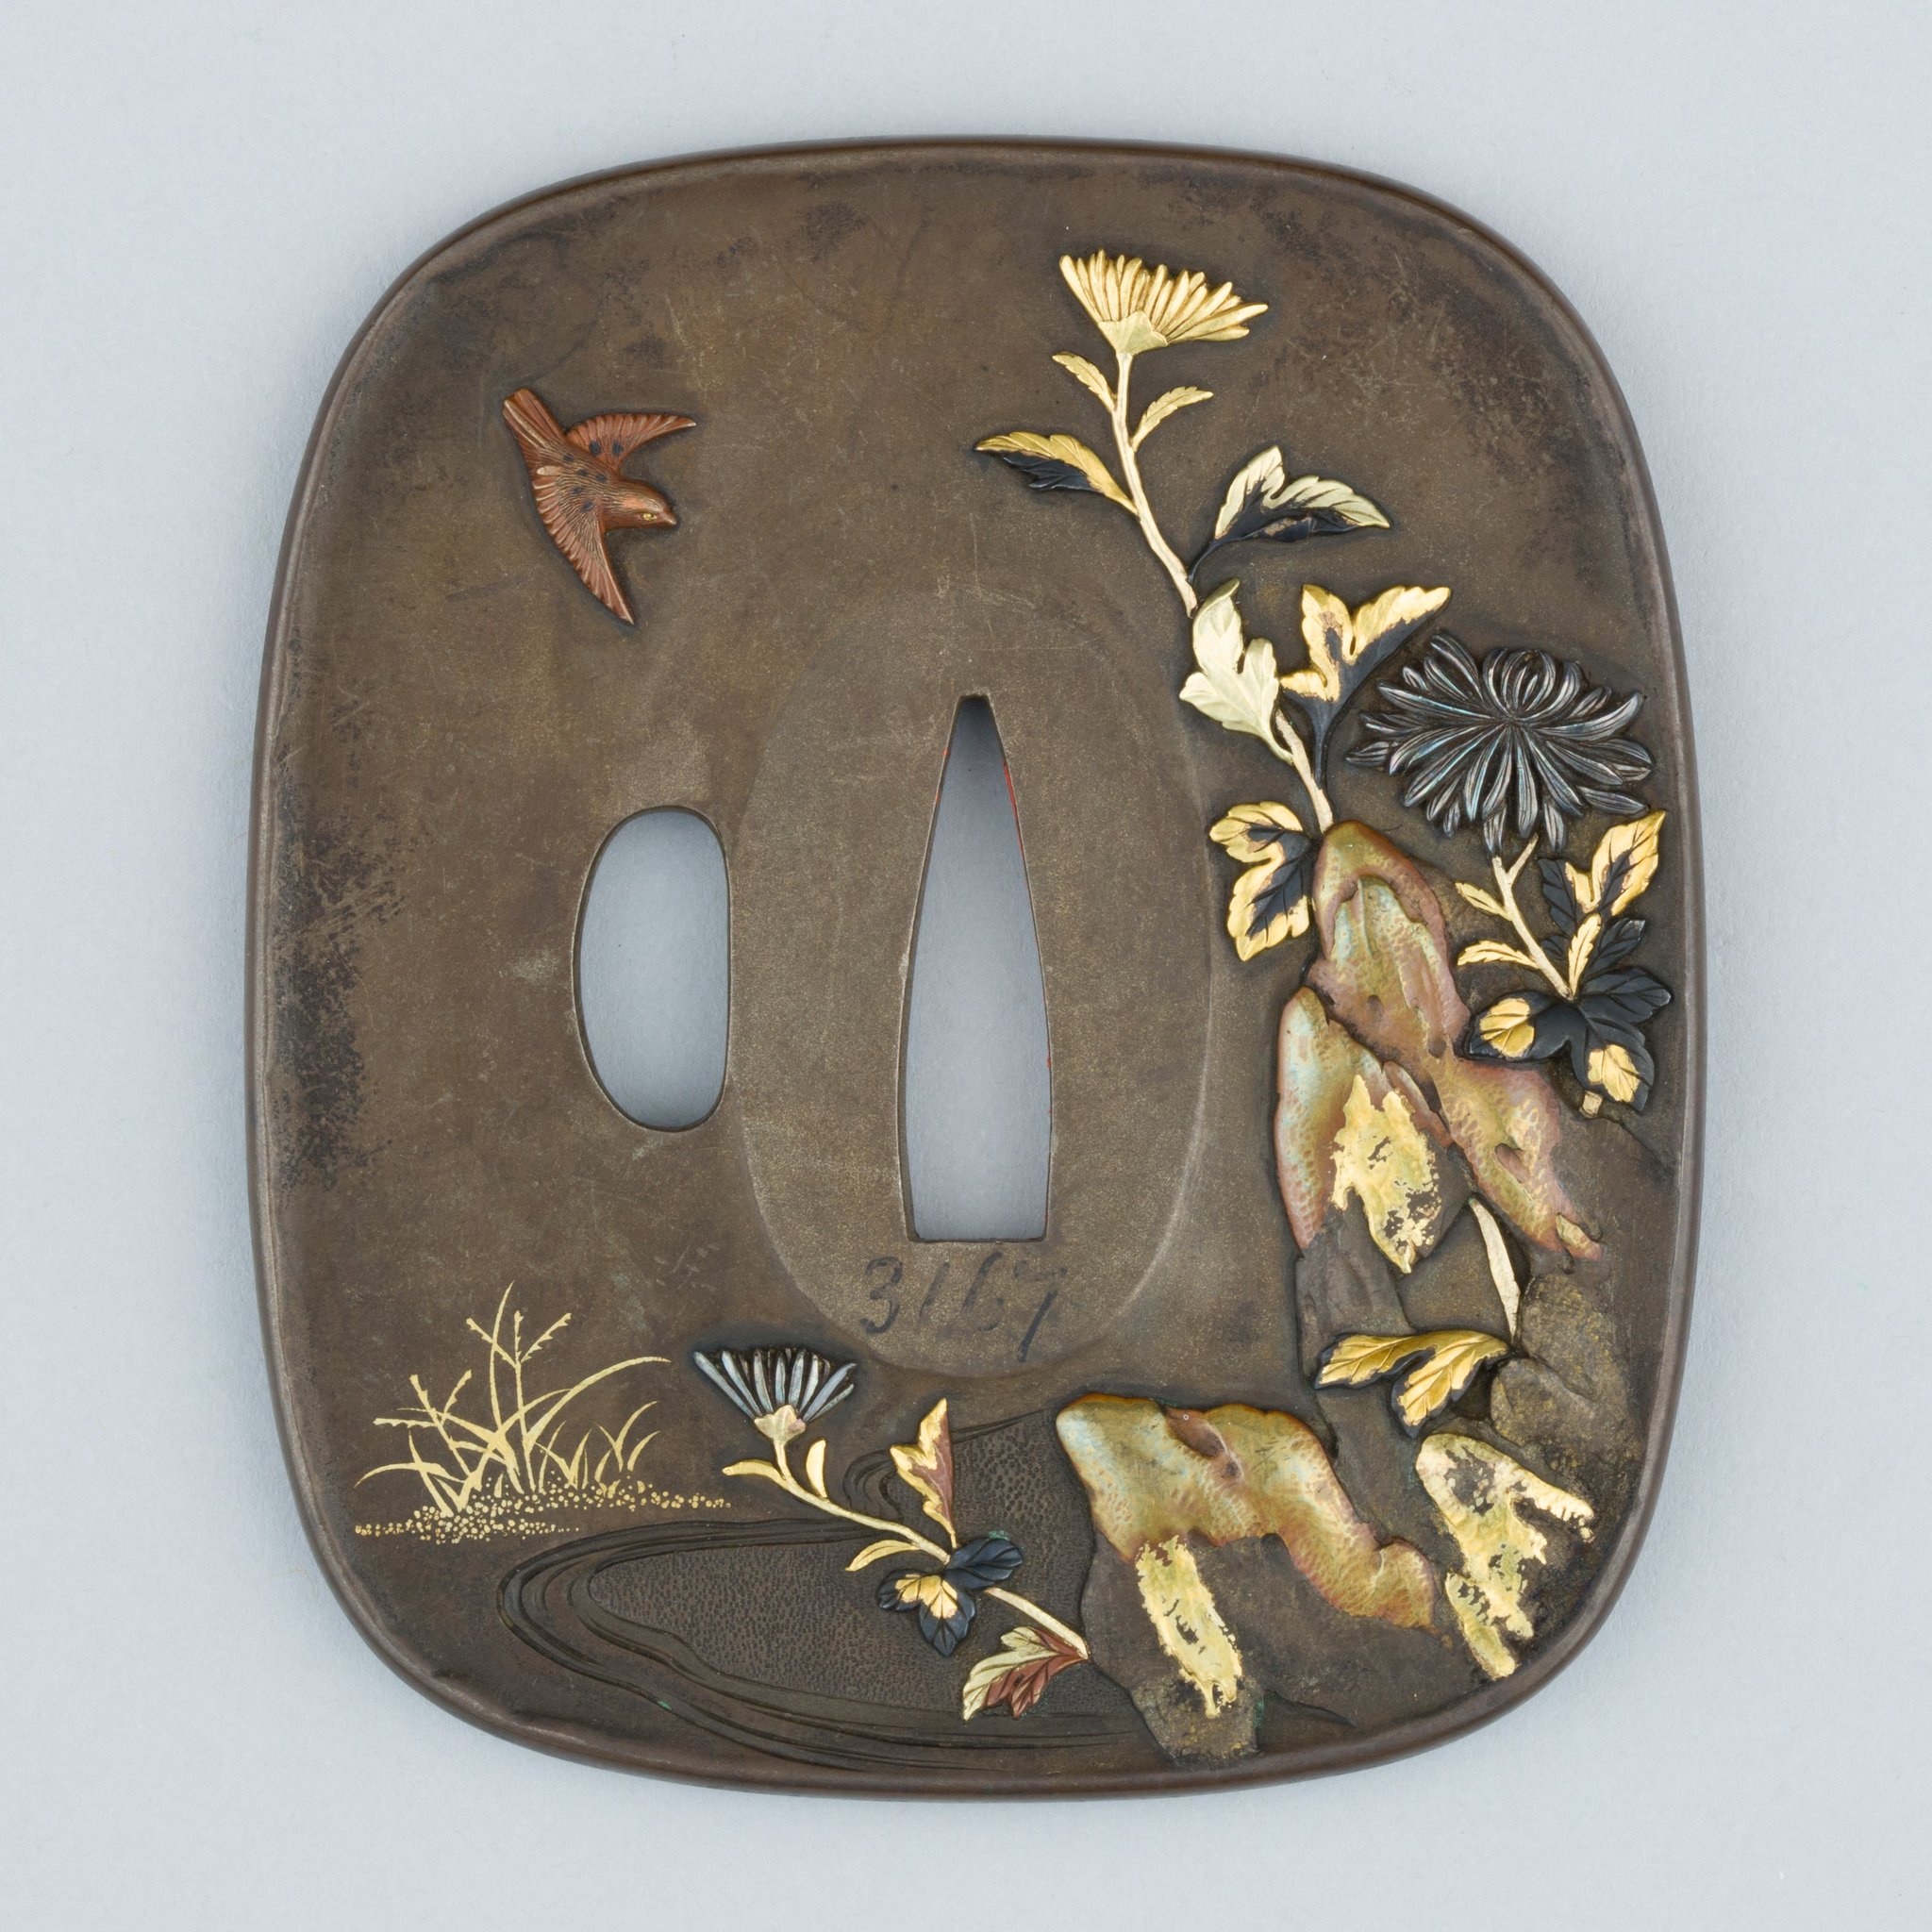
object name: sword guard tsuba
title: Sword Guard (Tsuba)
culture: japanese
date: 1615-1868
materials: copper, gold alloy, silver alloy, gold, silver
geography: japan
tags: flowers